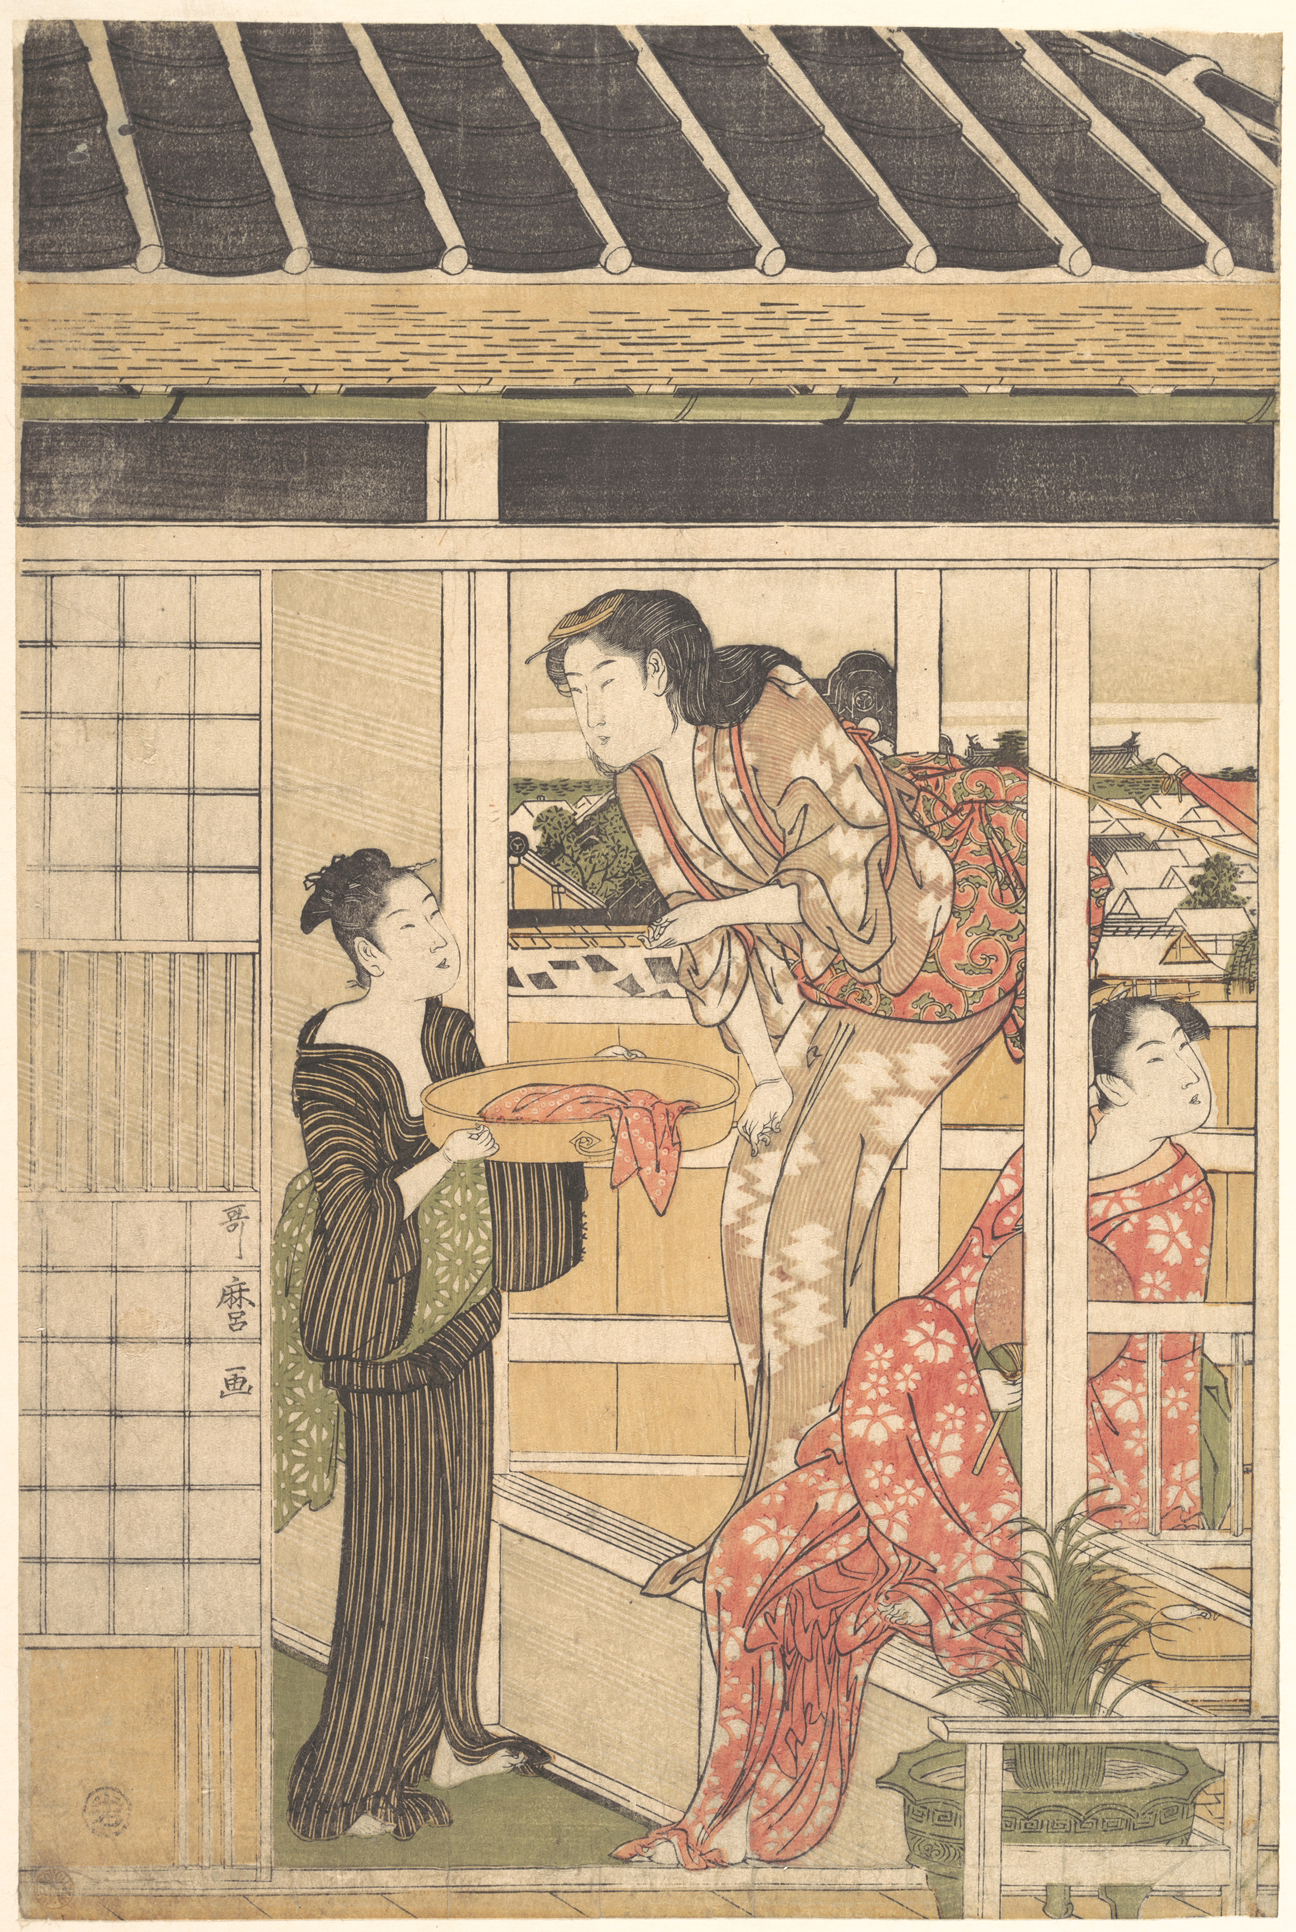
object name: print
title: Washing Day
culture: japanese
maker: kitagawa utamaro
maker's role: artist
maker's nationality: japanese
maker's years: 1754-1806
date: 1788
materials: ink, paper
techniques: woodblock print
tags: women